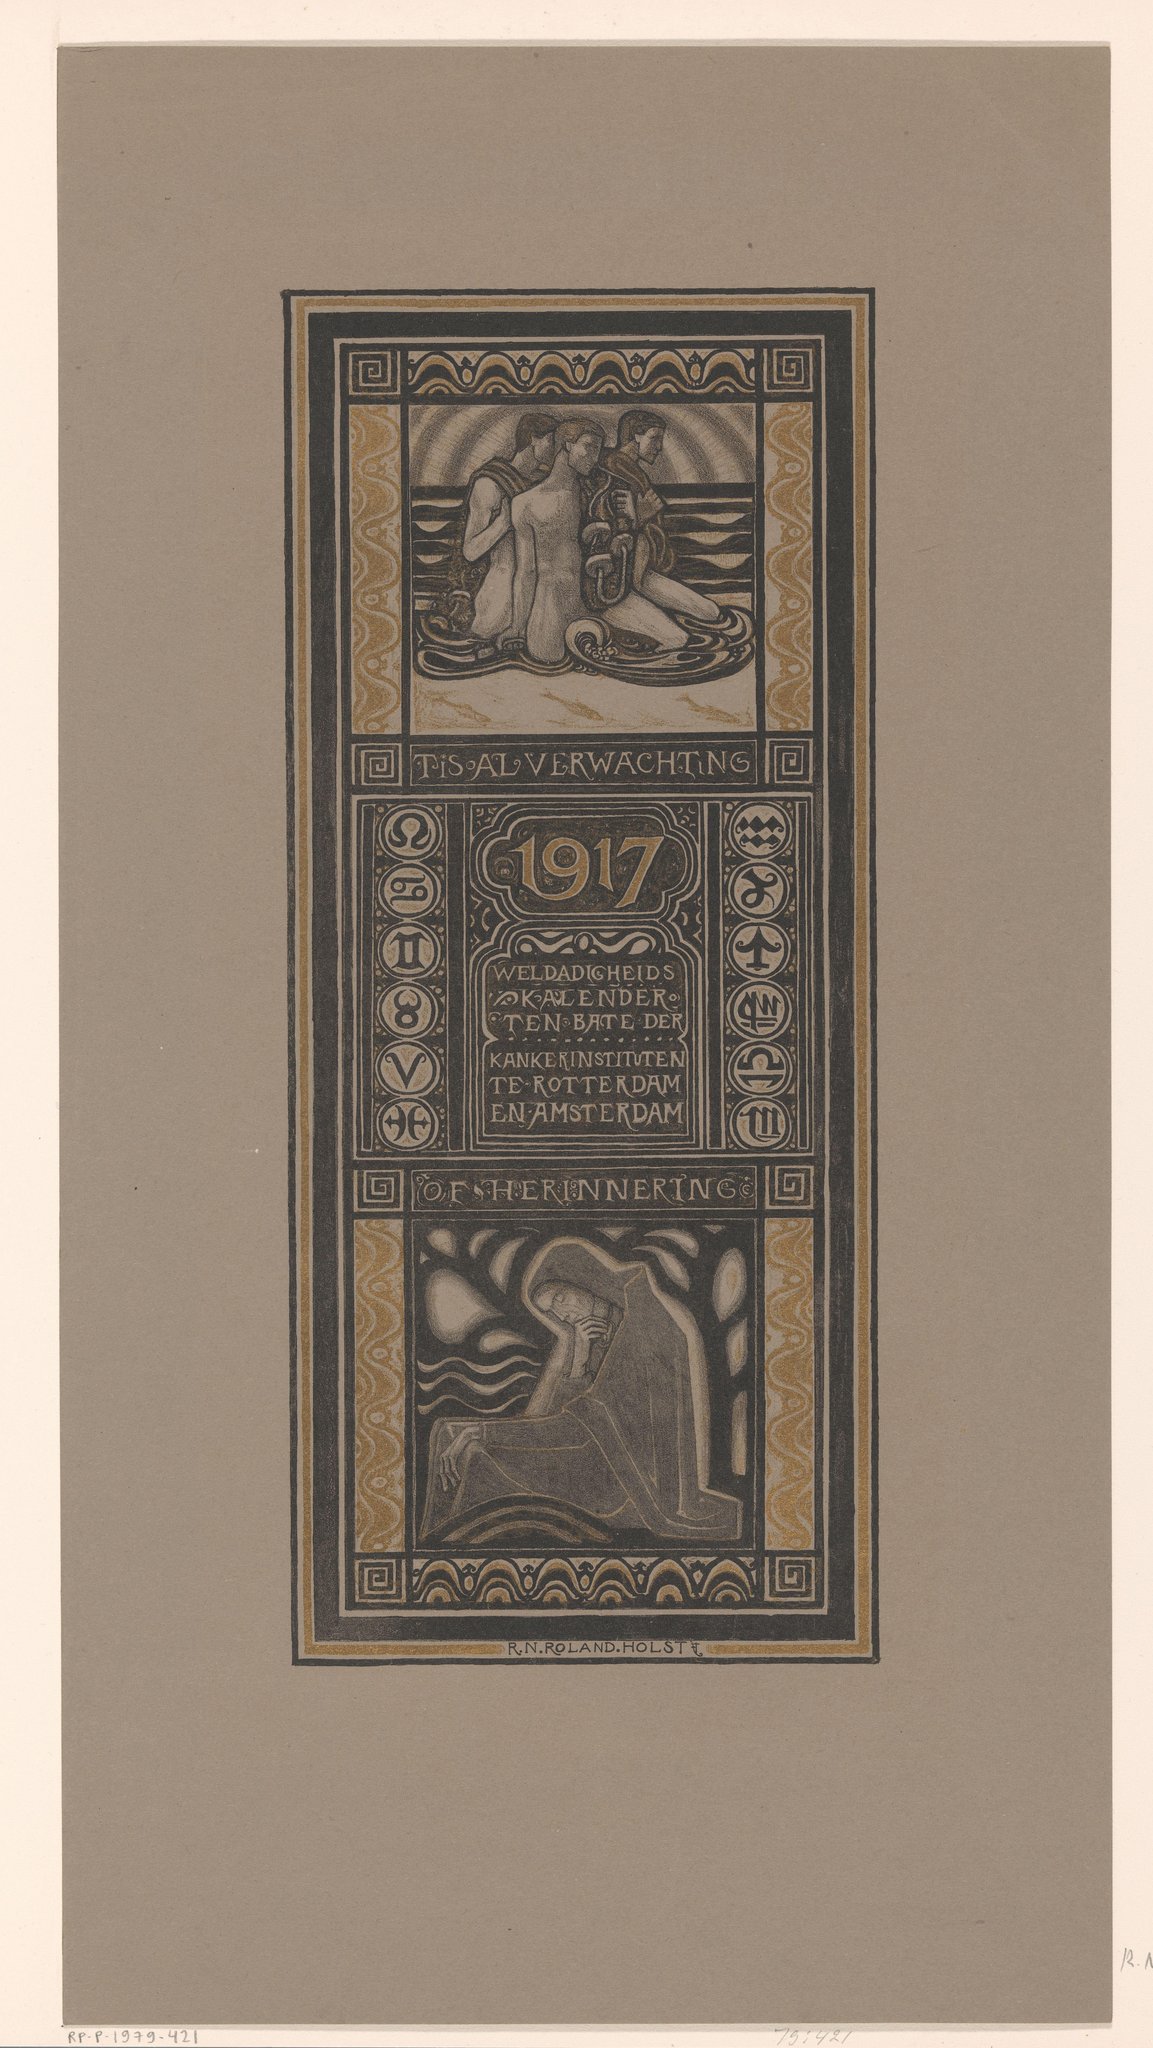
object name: calendar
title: 't Is al verwachting of herinnering: Weldadigheidskalender ten bate der kankerinstituten te Rotterdam en Amsterdam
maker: richard nicolaüs roland holst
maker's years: 1868-1938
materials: paper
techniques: lithograph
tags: wave, habit, frock, zodiac; the twelve zodiacal signs together, man (showing himself) undressed, quasi-nude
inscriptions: collector's mark: Lugt 2228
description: Een rechthoekig kader met bovenaan drie staande, naakte mannen in de golven, in het midden de twaalf tekens van de dierenriem, en onderaan een geknielde figuur in een habijt.